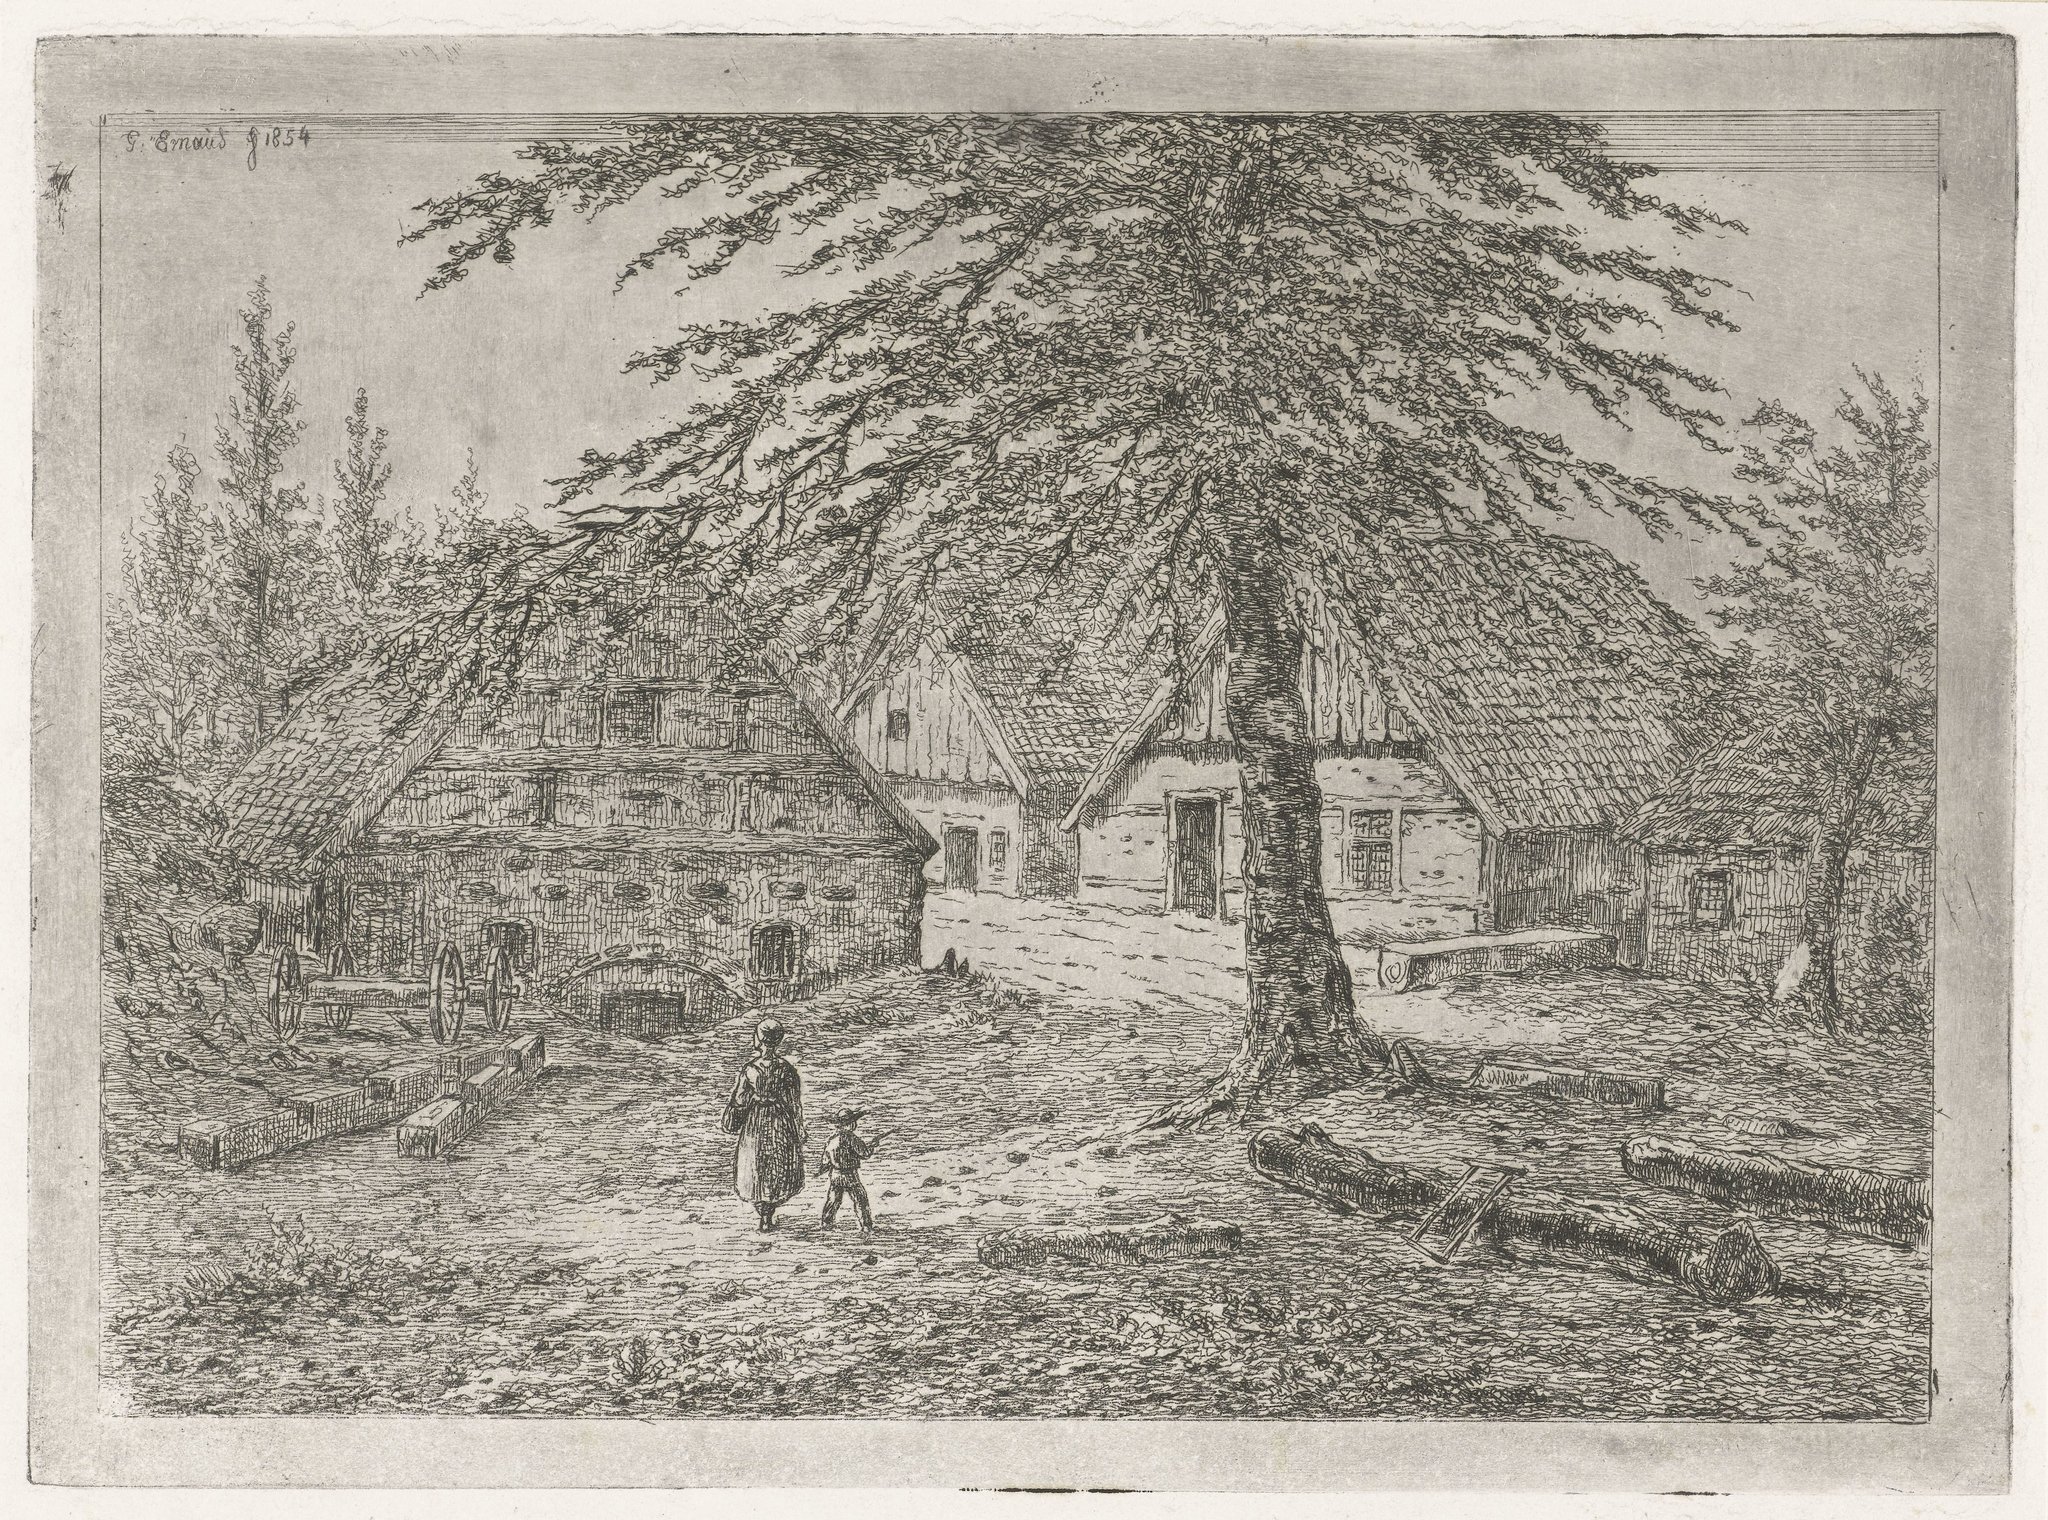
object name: print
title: De houtzagerij te Bentheim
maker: gerardus emaus de micault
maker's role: draughtsman, print maker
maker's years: 1798-1863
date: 1854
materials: paper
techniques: etching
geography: netherlands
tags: sawyer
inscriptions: collector's mark: Lugt 2228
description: Op een erf met verschillende schuren, een grote boom en enkele afgezaagde boomstammen lopen een vrouw en een kind.